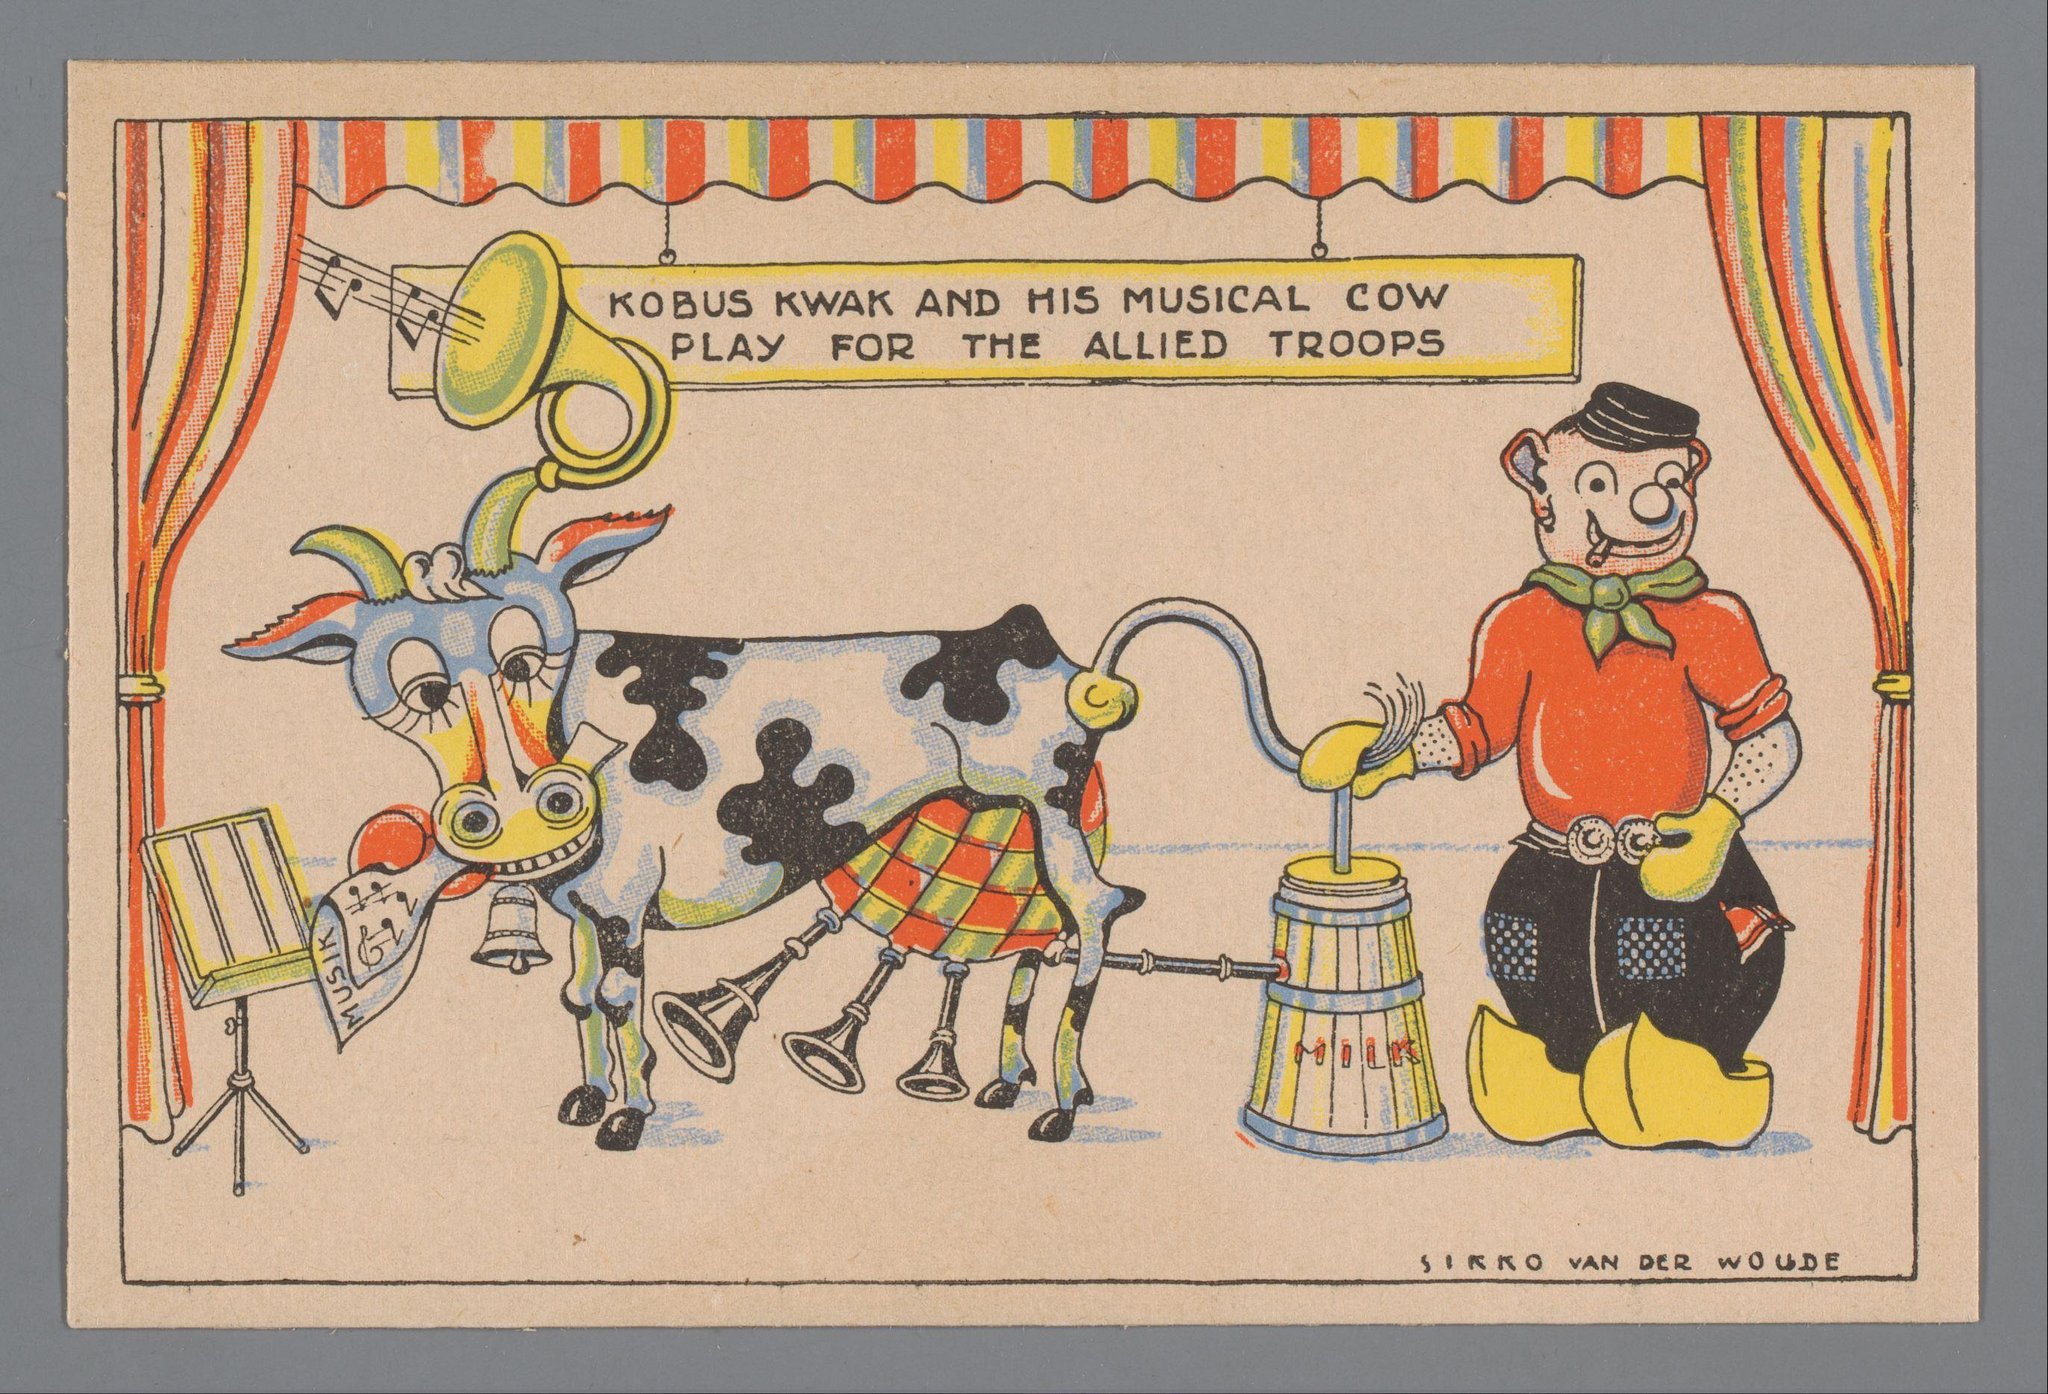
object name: postcard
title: Picture post card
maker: sima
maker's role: publisher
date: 1945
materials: paper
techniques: printing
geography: netherlands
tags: netherlands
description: Eén van acht 'grappige' prentbriefkaarten, tekeningen in kleur van in klederdracht gestoken Nederlanders en (meest schotse) soldaten. Opmerking: Acht briefkaarten in envelope met tekst in rood en blauw in rood-wit-blauw kader.